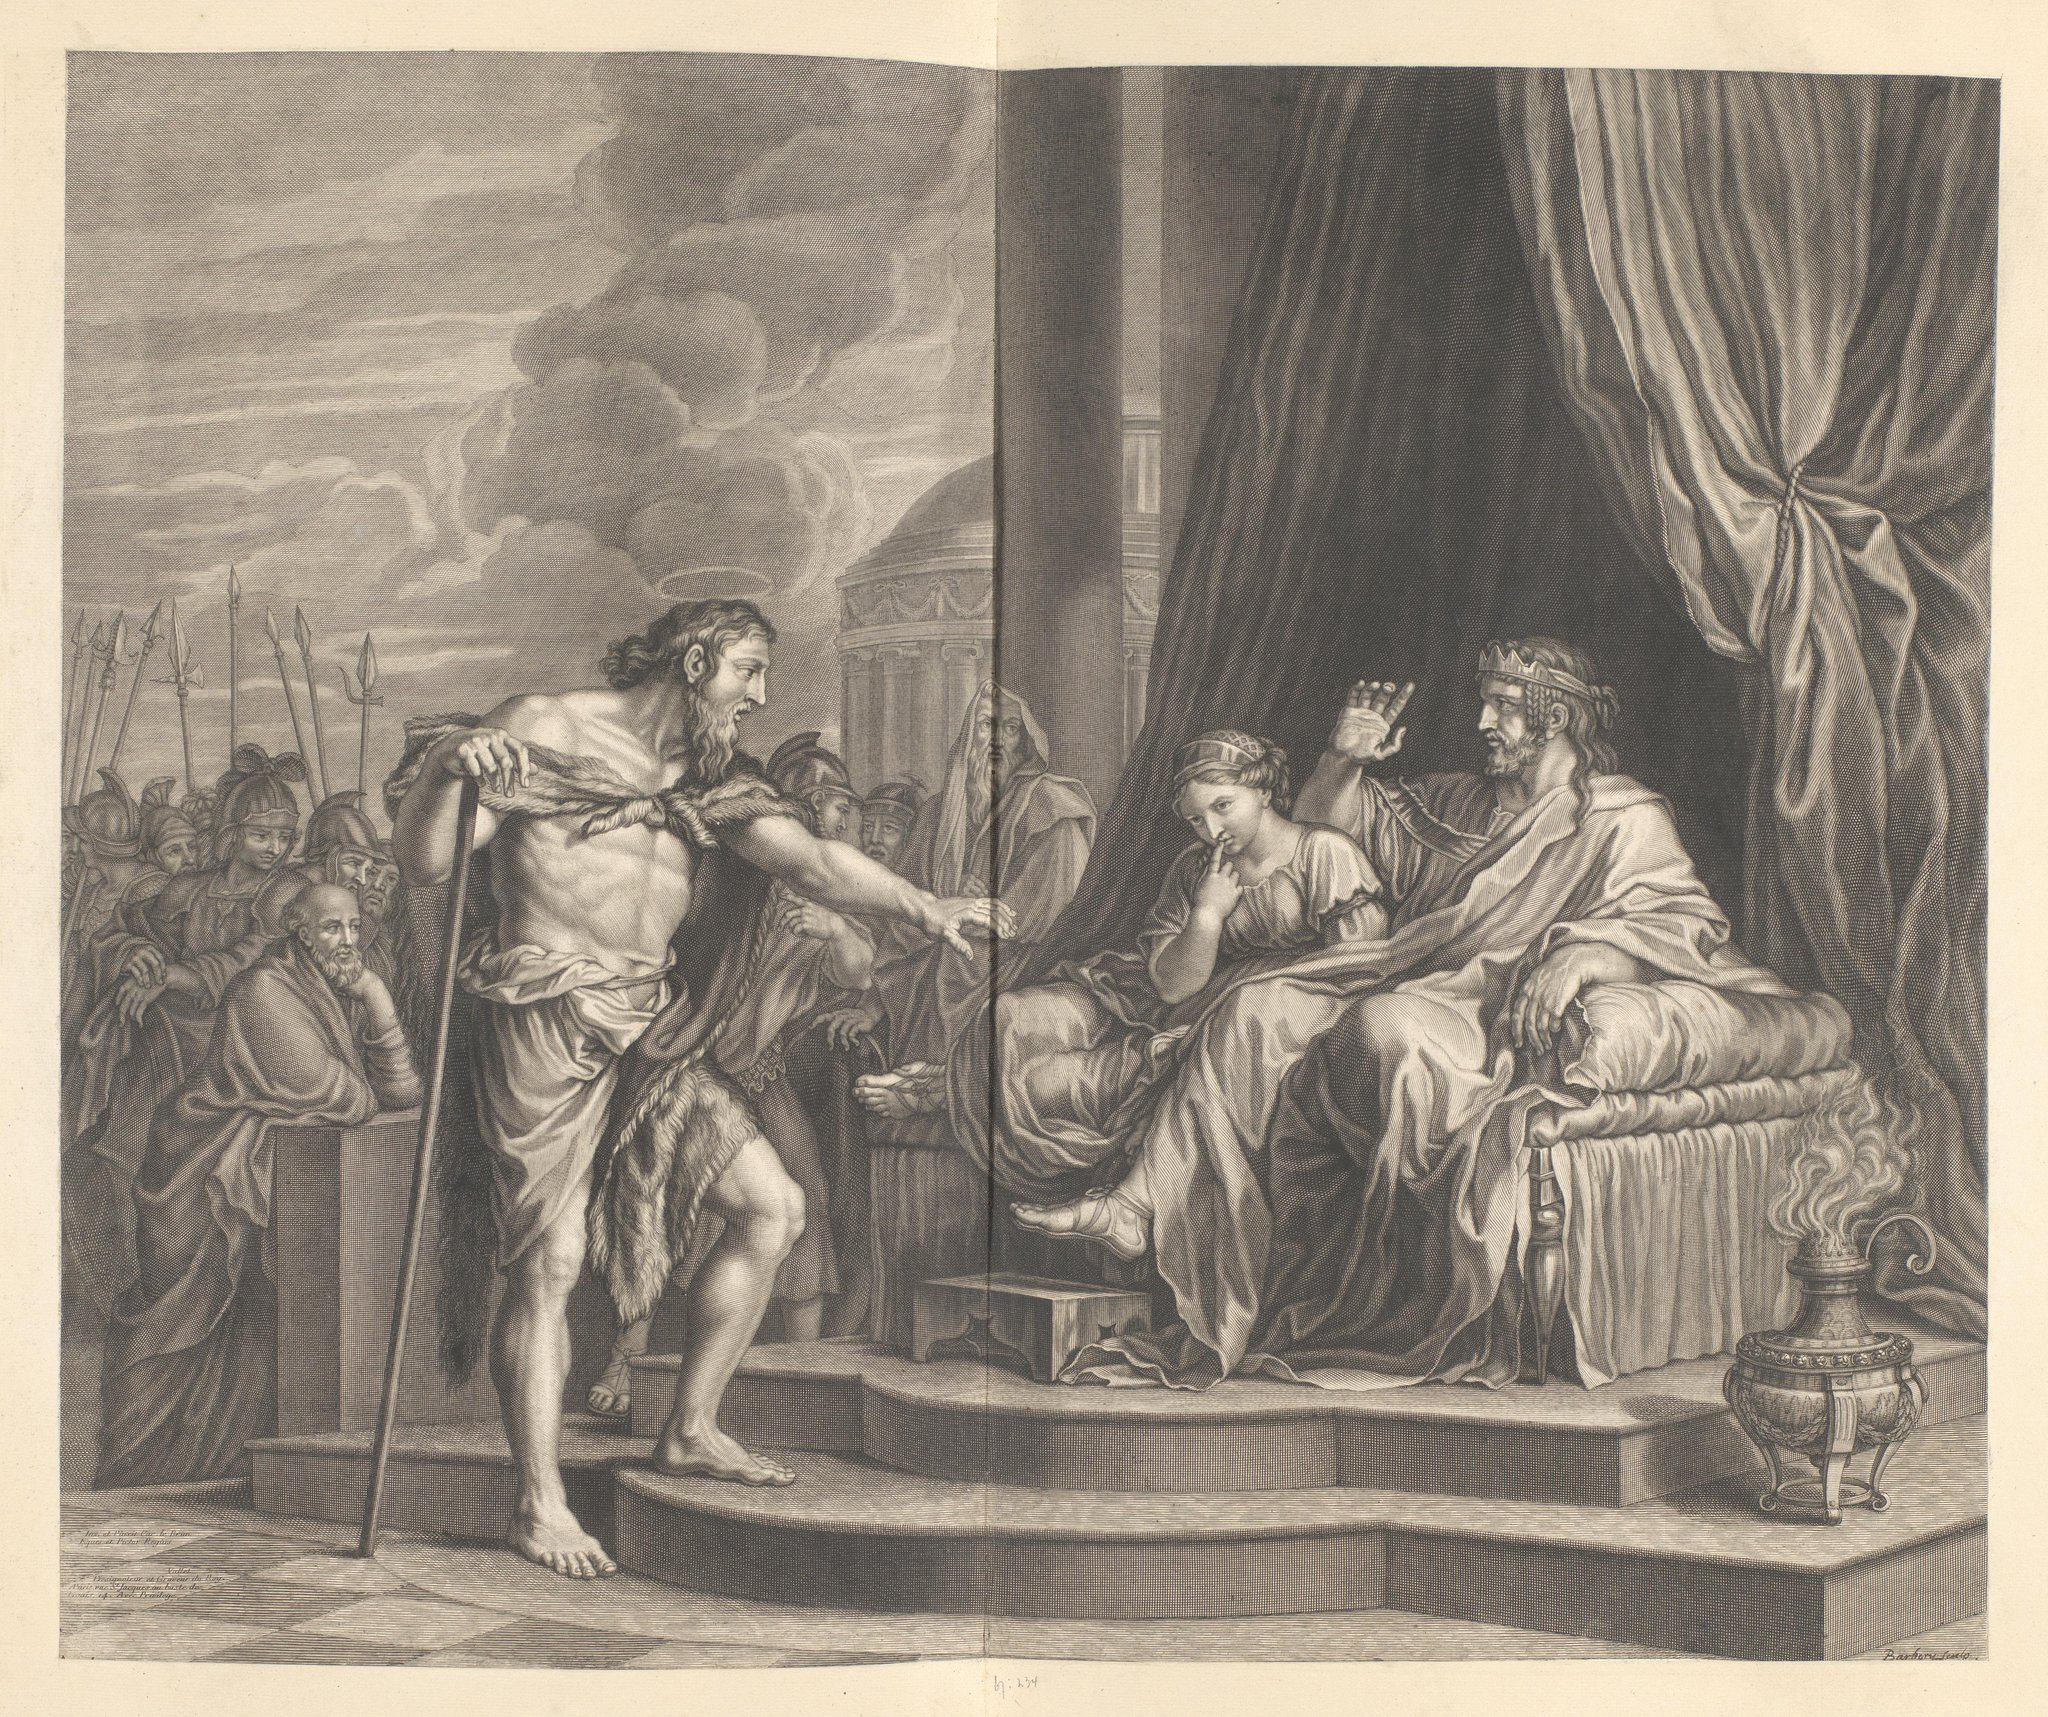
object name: print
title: Werken van Charles le Brun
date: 1642-1704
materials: paper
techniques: engraving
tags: john the baptist reproaches herod (herod antipas) and herodias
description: In het naslagwerk van Wildenstein is deze prent afgebeeld met onder de gravure een kader met daarin een opdracht aan Gabriel Jean-Baptiste de Lagny. Dit deel ontbreekt aan dit exemplaar.